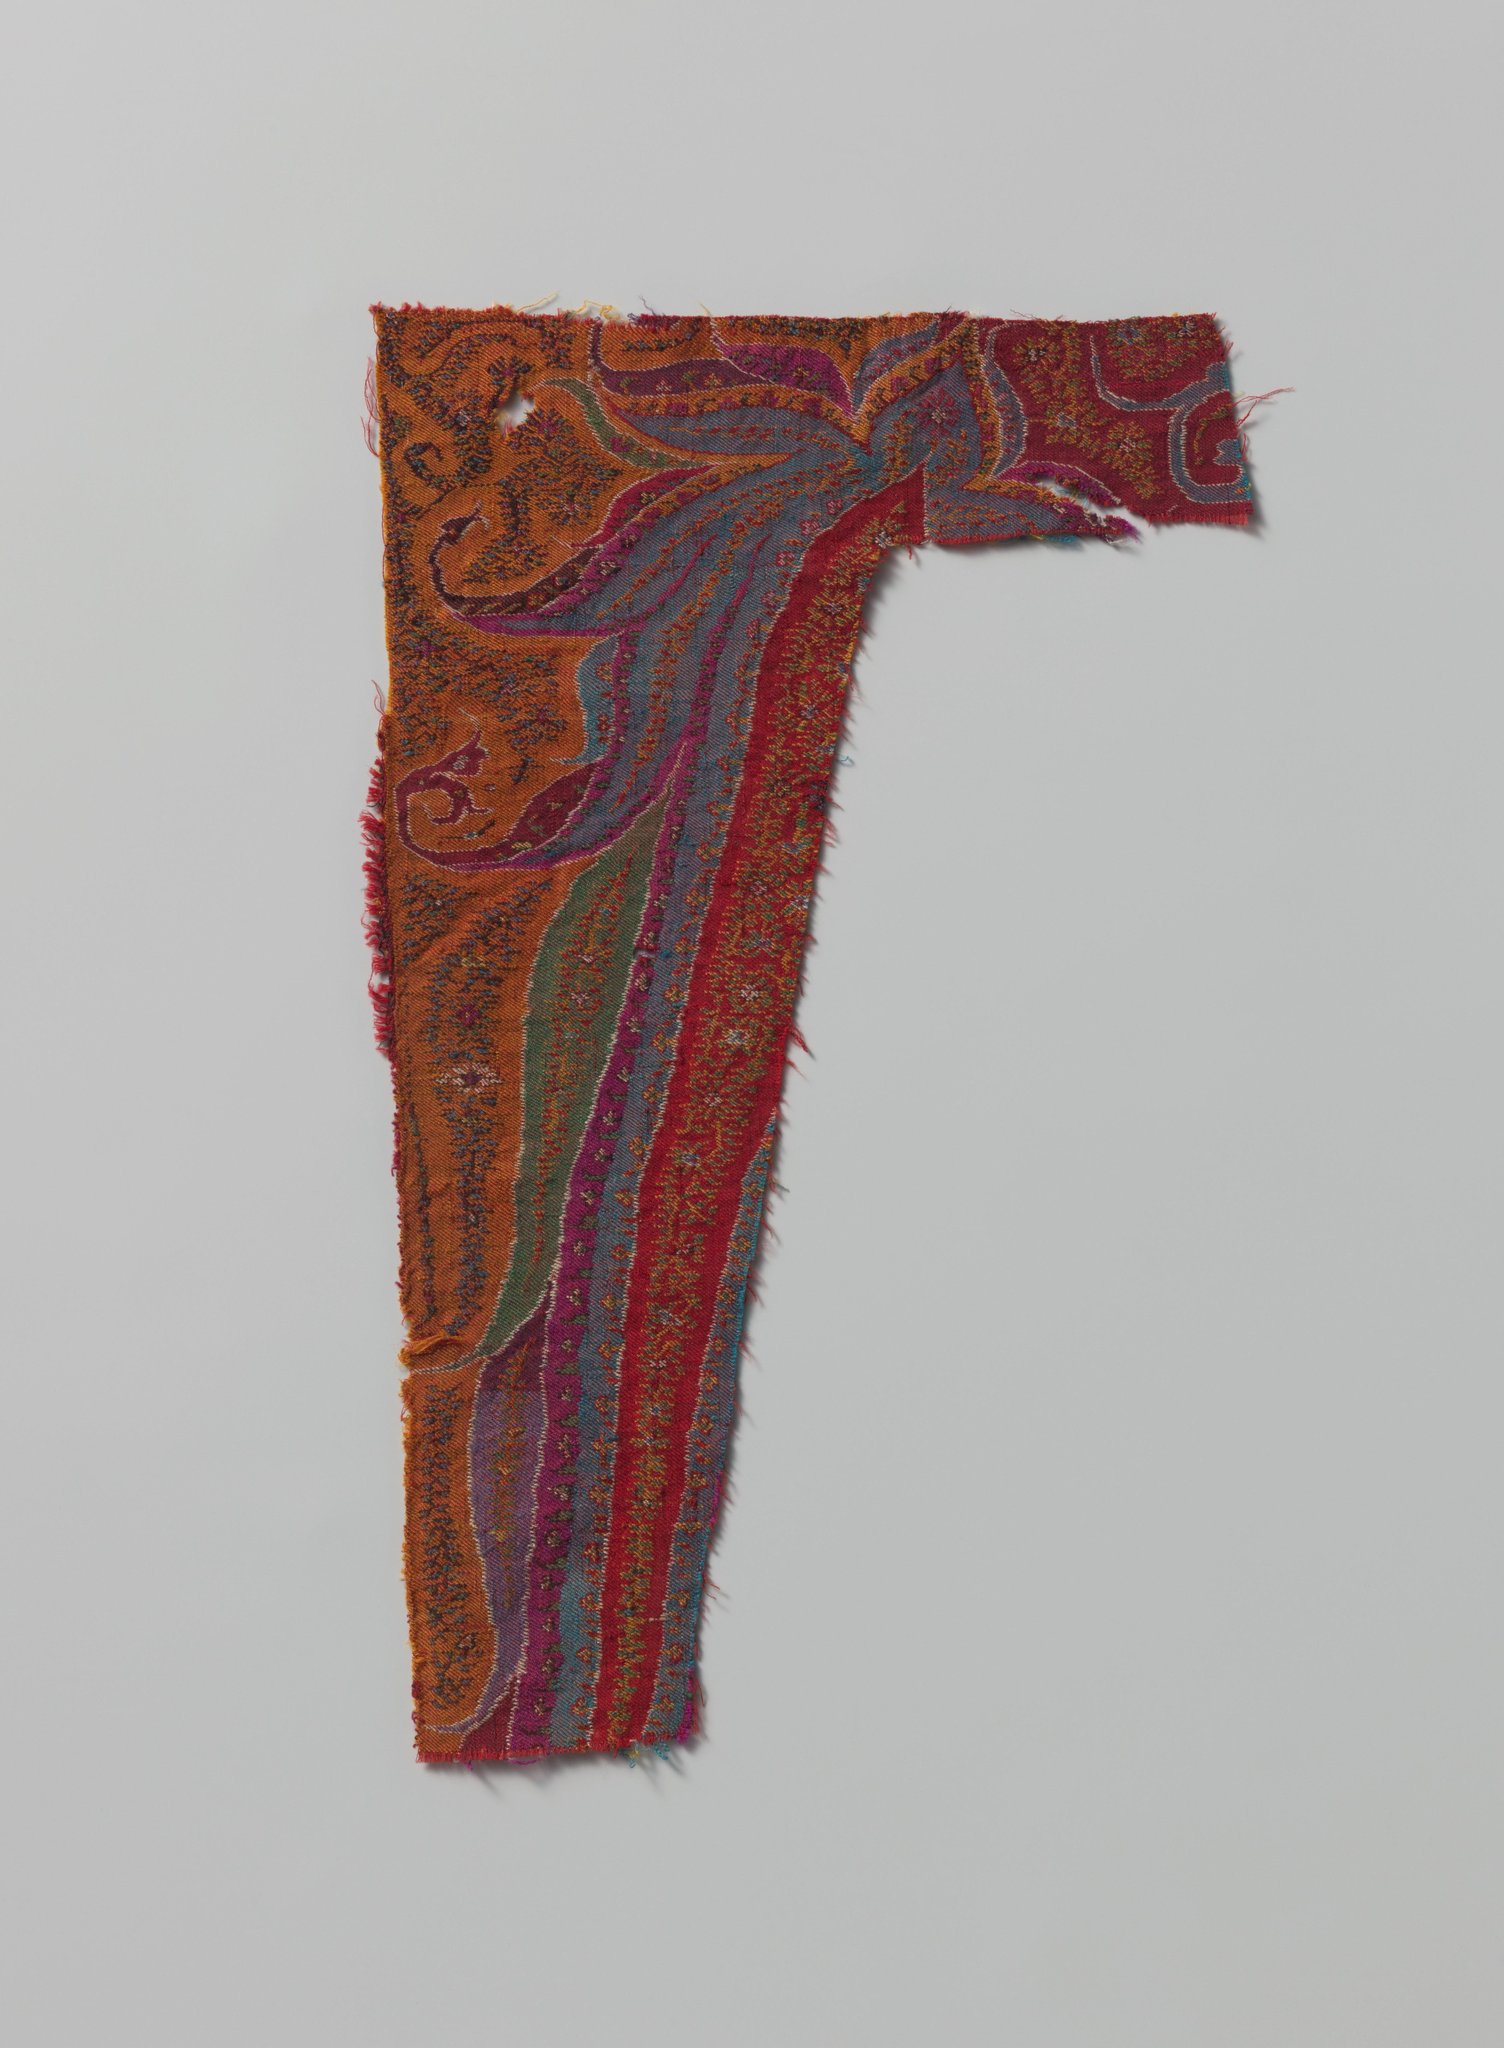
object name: fragment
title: Fragment van kasjmiersjaal van wol met patroon van langgerekt veermotief in hart van blauw bladrozet met purperpaarse omlijstingen en arabesk-voluten van aubergine, allen met witte rand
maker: Anonymous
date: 1860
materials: wool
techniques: weave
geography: kashmir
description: Fragment van kasjmiersjaal van wol met patroon van langgerekt veermotief in hart van blauw bladrozet met purperpaarse omlijstingen en arabesk-voluten van aubergine, alle met witte rand. Patroon: een langgerekt veermotief van terra vormt het hart van een blauw bladrozet met purperpaarse omlijstingen en arabesk-voluten van aubergine. Alles witgerand. Rechts een deel van de oranje grond, waarop een fijne tekening van S-randjes met bloempjes voorkomt. Techniek: ketting van wol, inslag van wol. Binding: S-keper van 2:2.